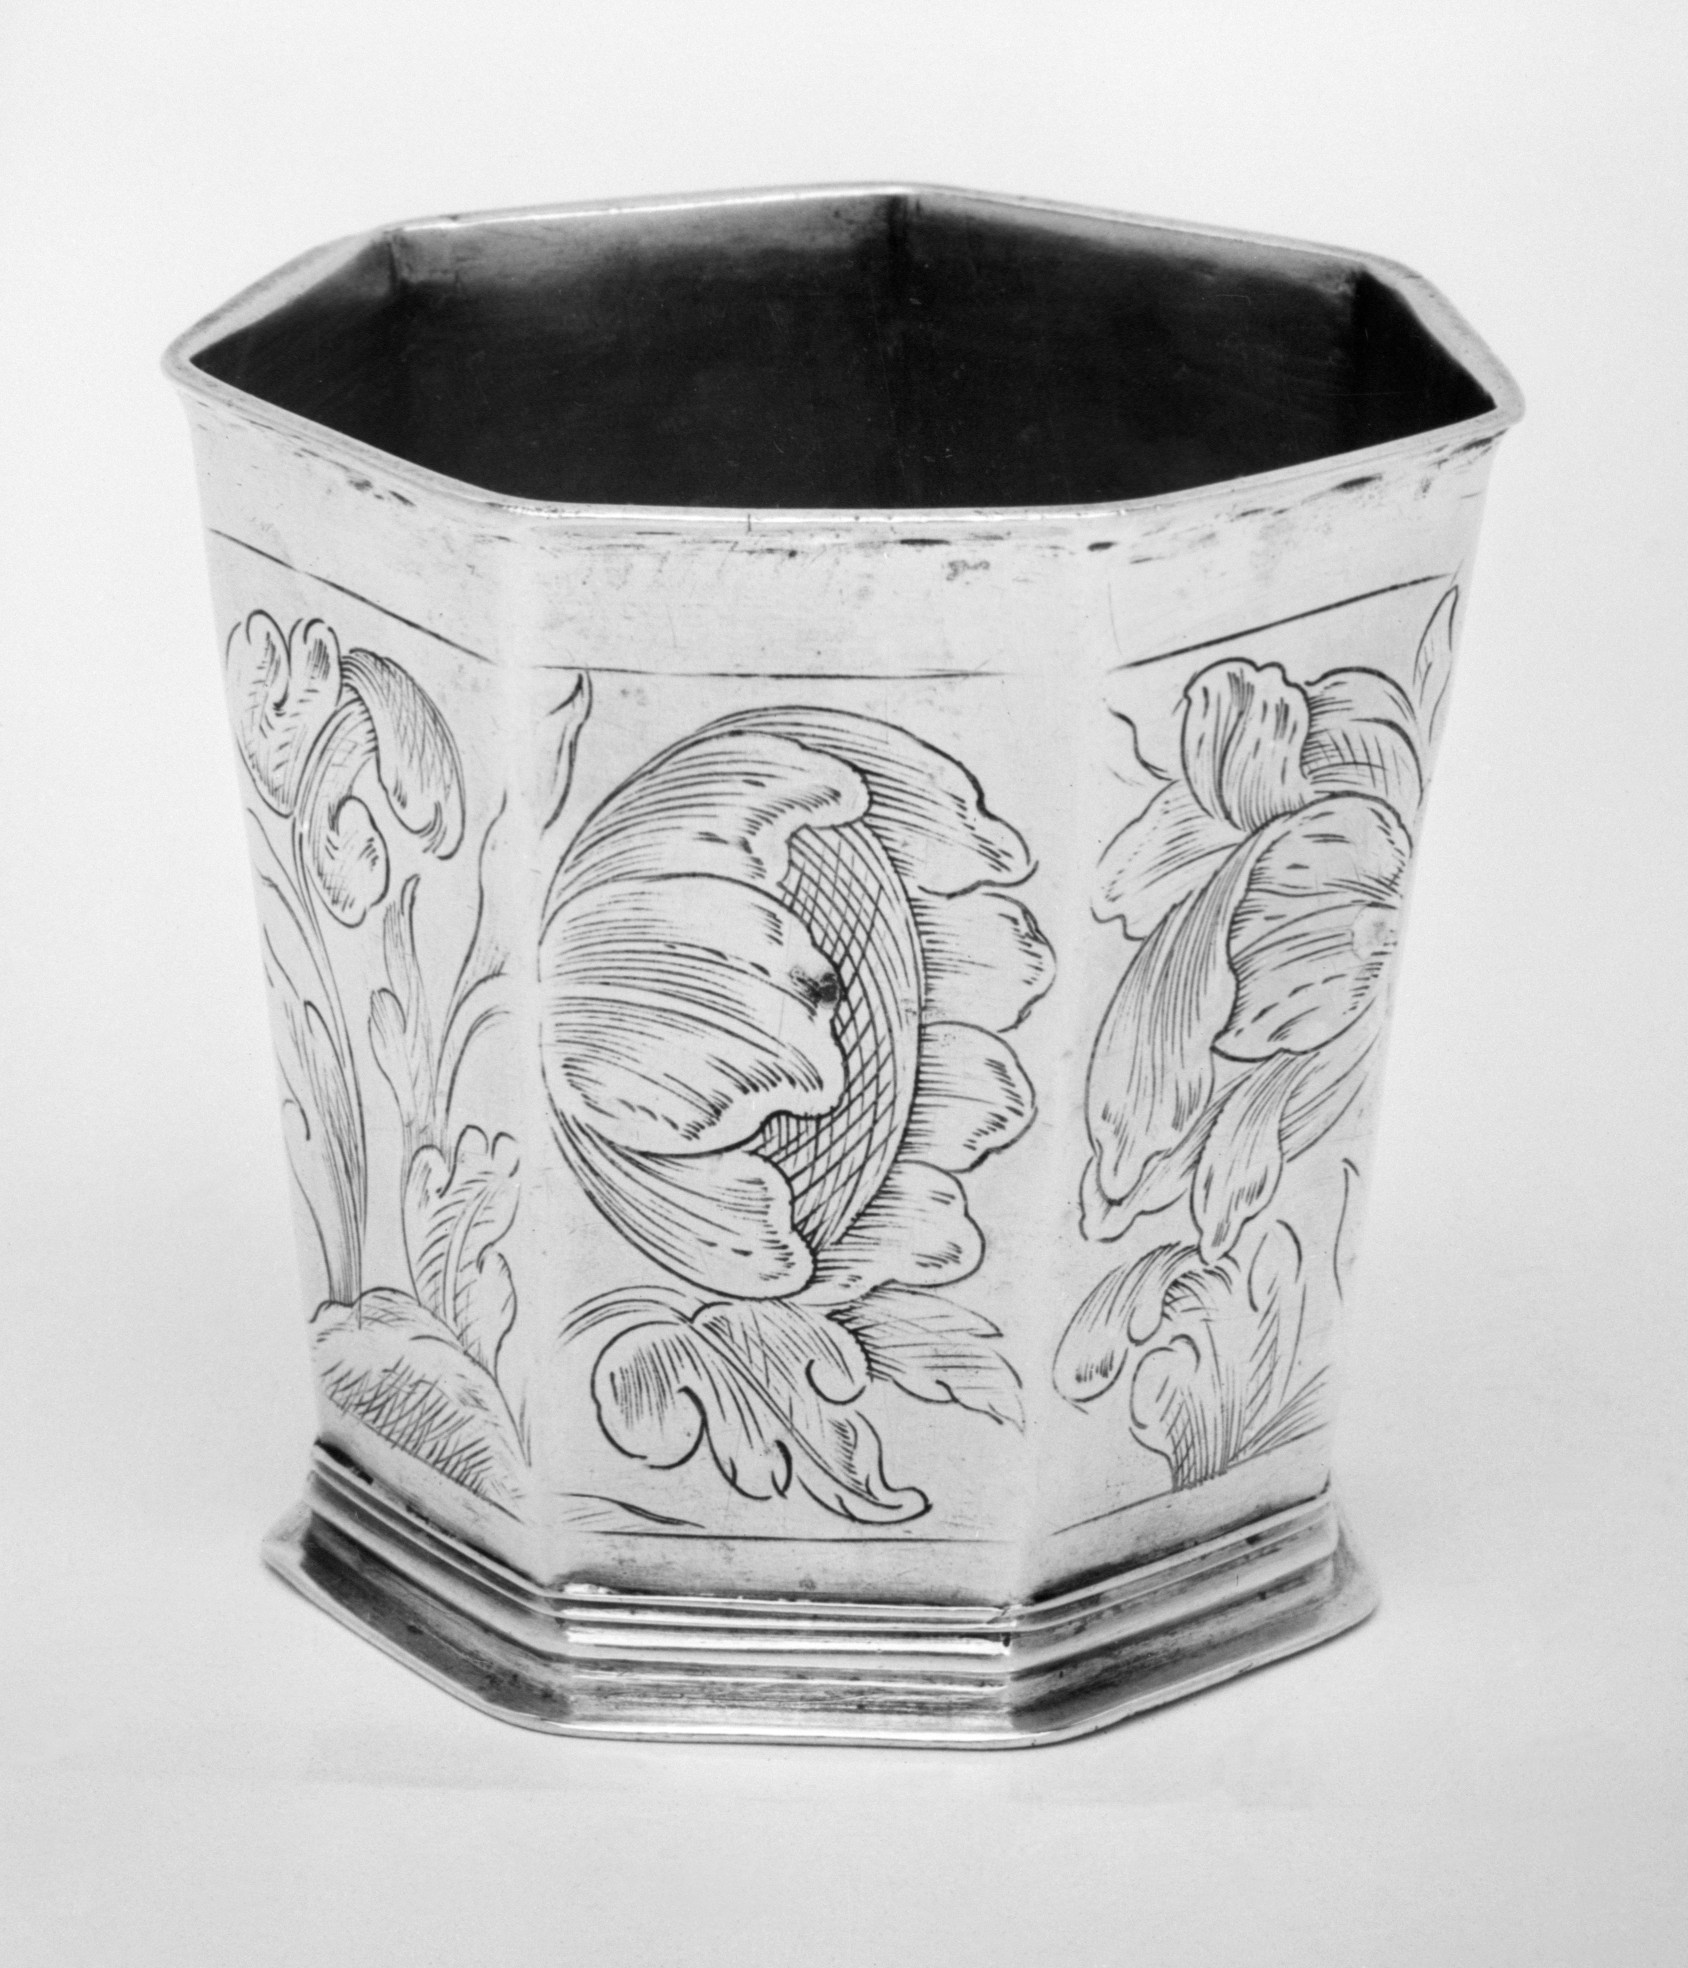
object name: beaker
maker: c.c., viborg, denmark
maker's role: maker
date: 1687-1688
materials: gilt, silver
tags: flowers